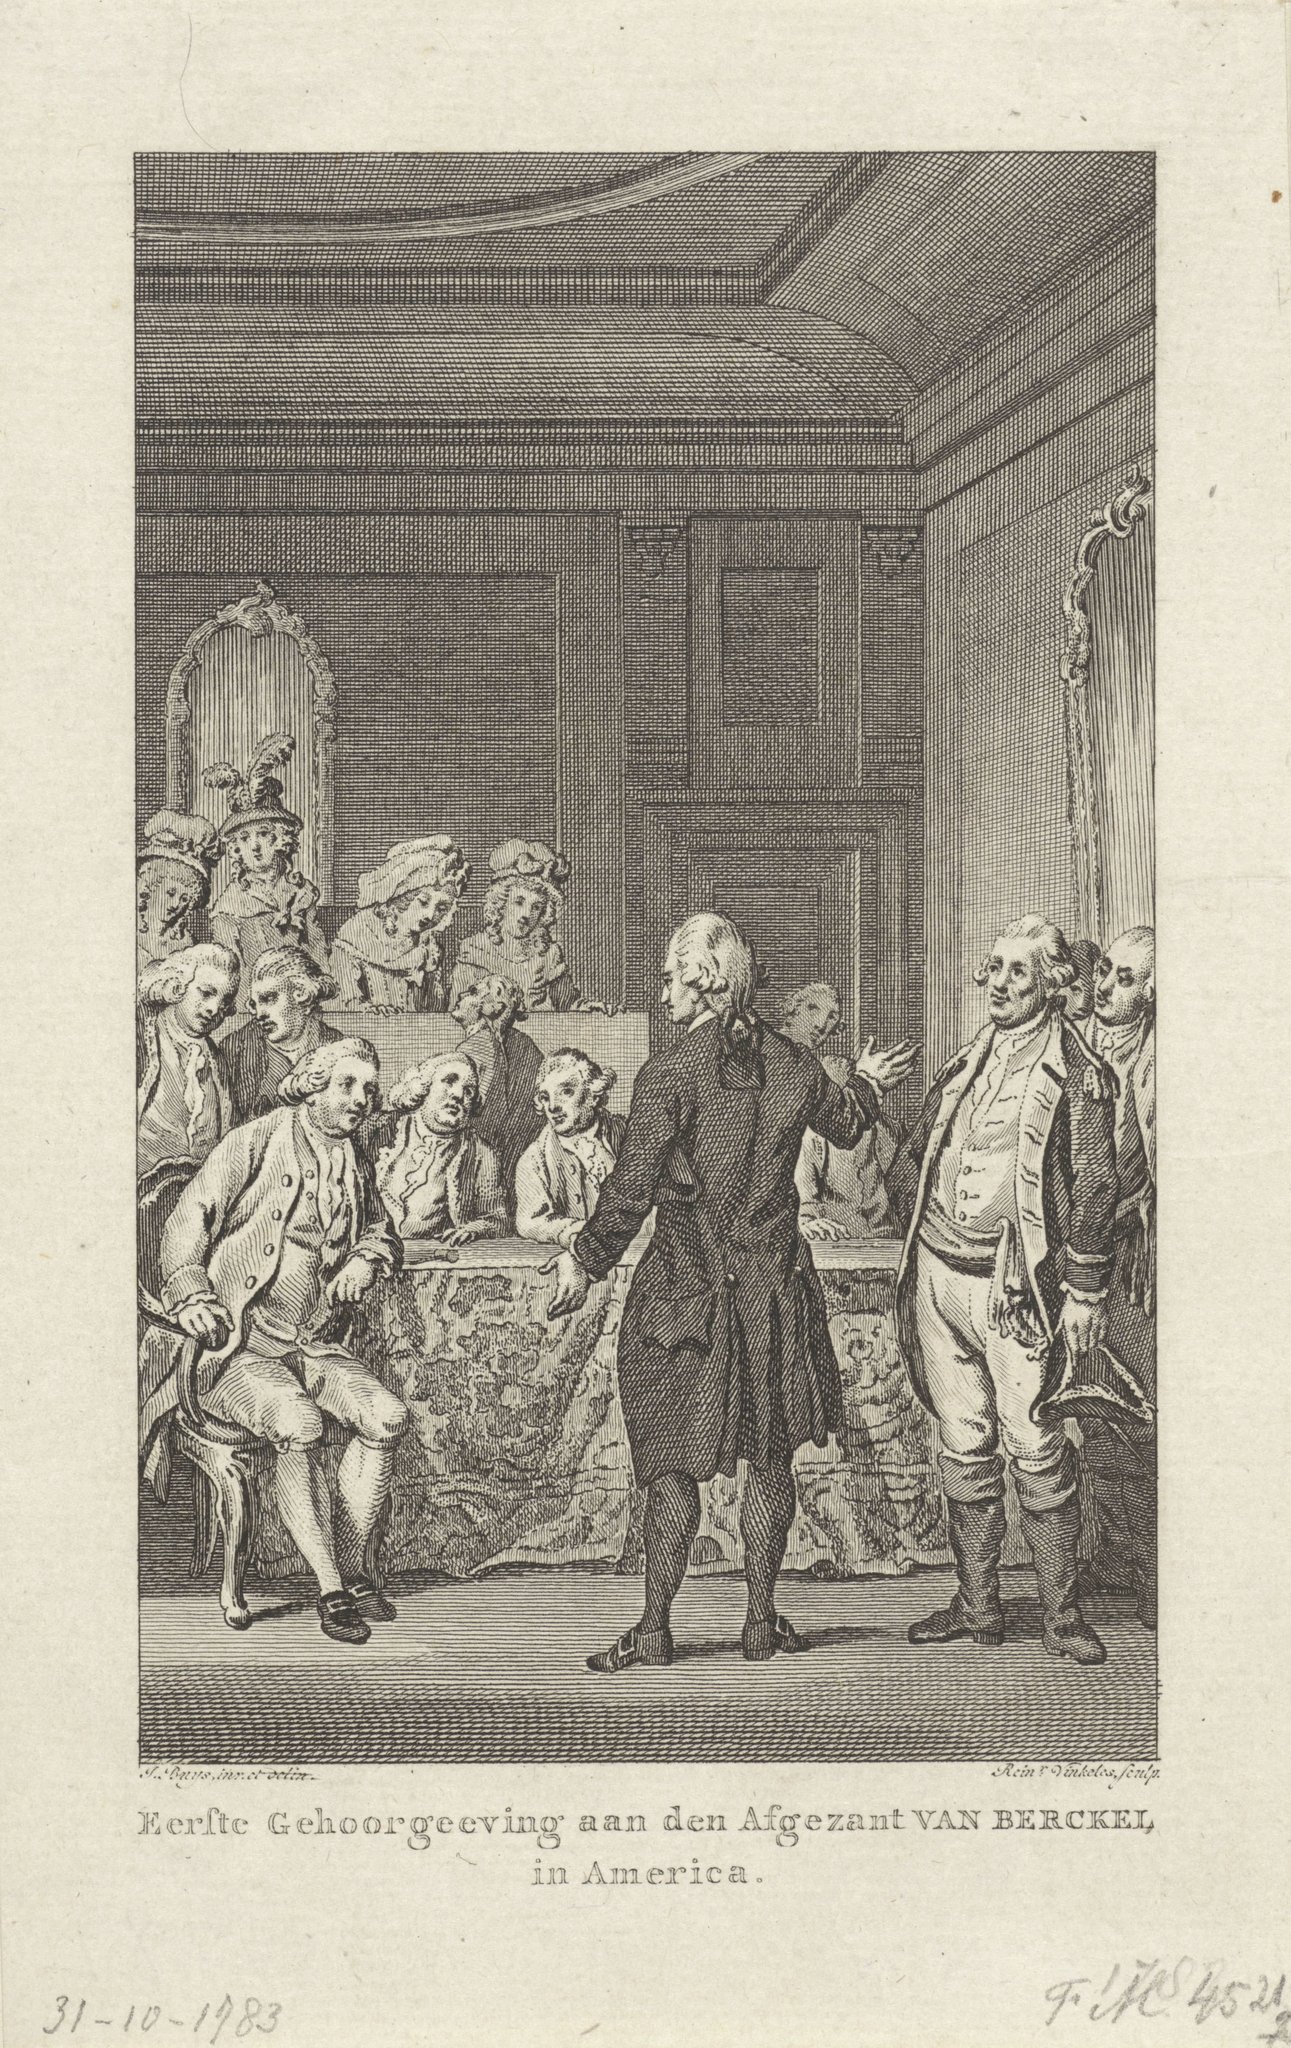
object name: history print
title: Ontvangst van de eerste Nederlandse gezant in de Amerikaanse senaat, 1783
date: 1788-1790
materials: paper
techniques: engraving, etching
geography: amsterdam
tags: rotterdam, mayor, united states of america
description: Gebruikt als illustratie in: P.A. Loosjes. Vaderlandsche historie, vervattende de geschiedenissen, der Vereenigde Nederlanden (...). Ten onmiddelyken vervolge van Wagenaar's Vaderlandsche historie. Amsterdam: Johannes Allart, dl. 5, 1790.